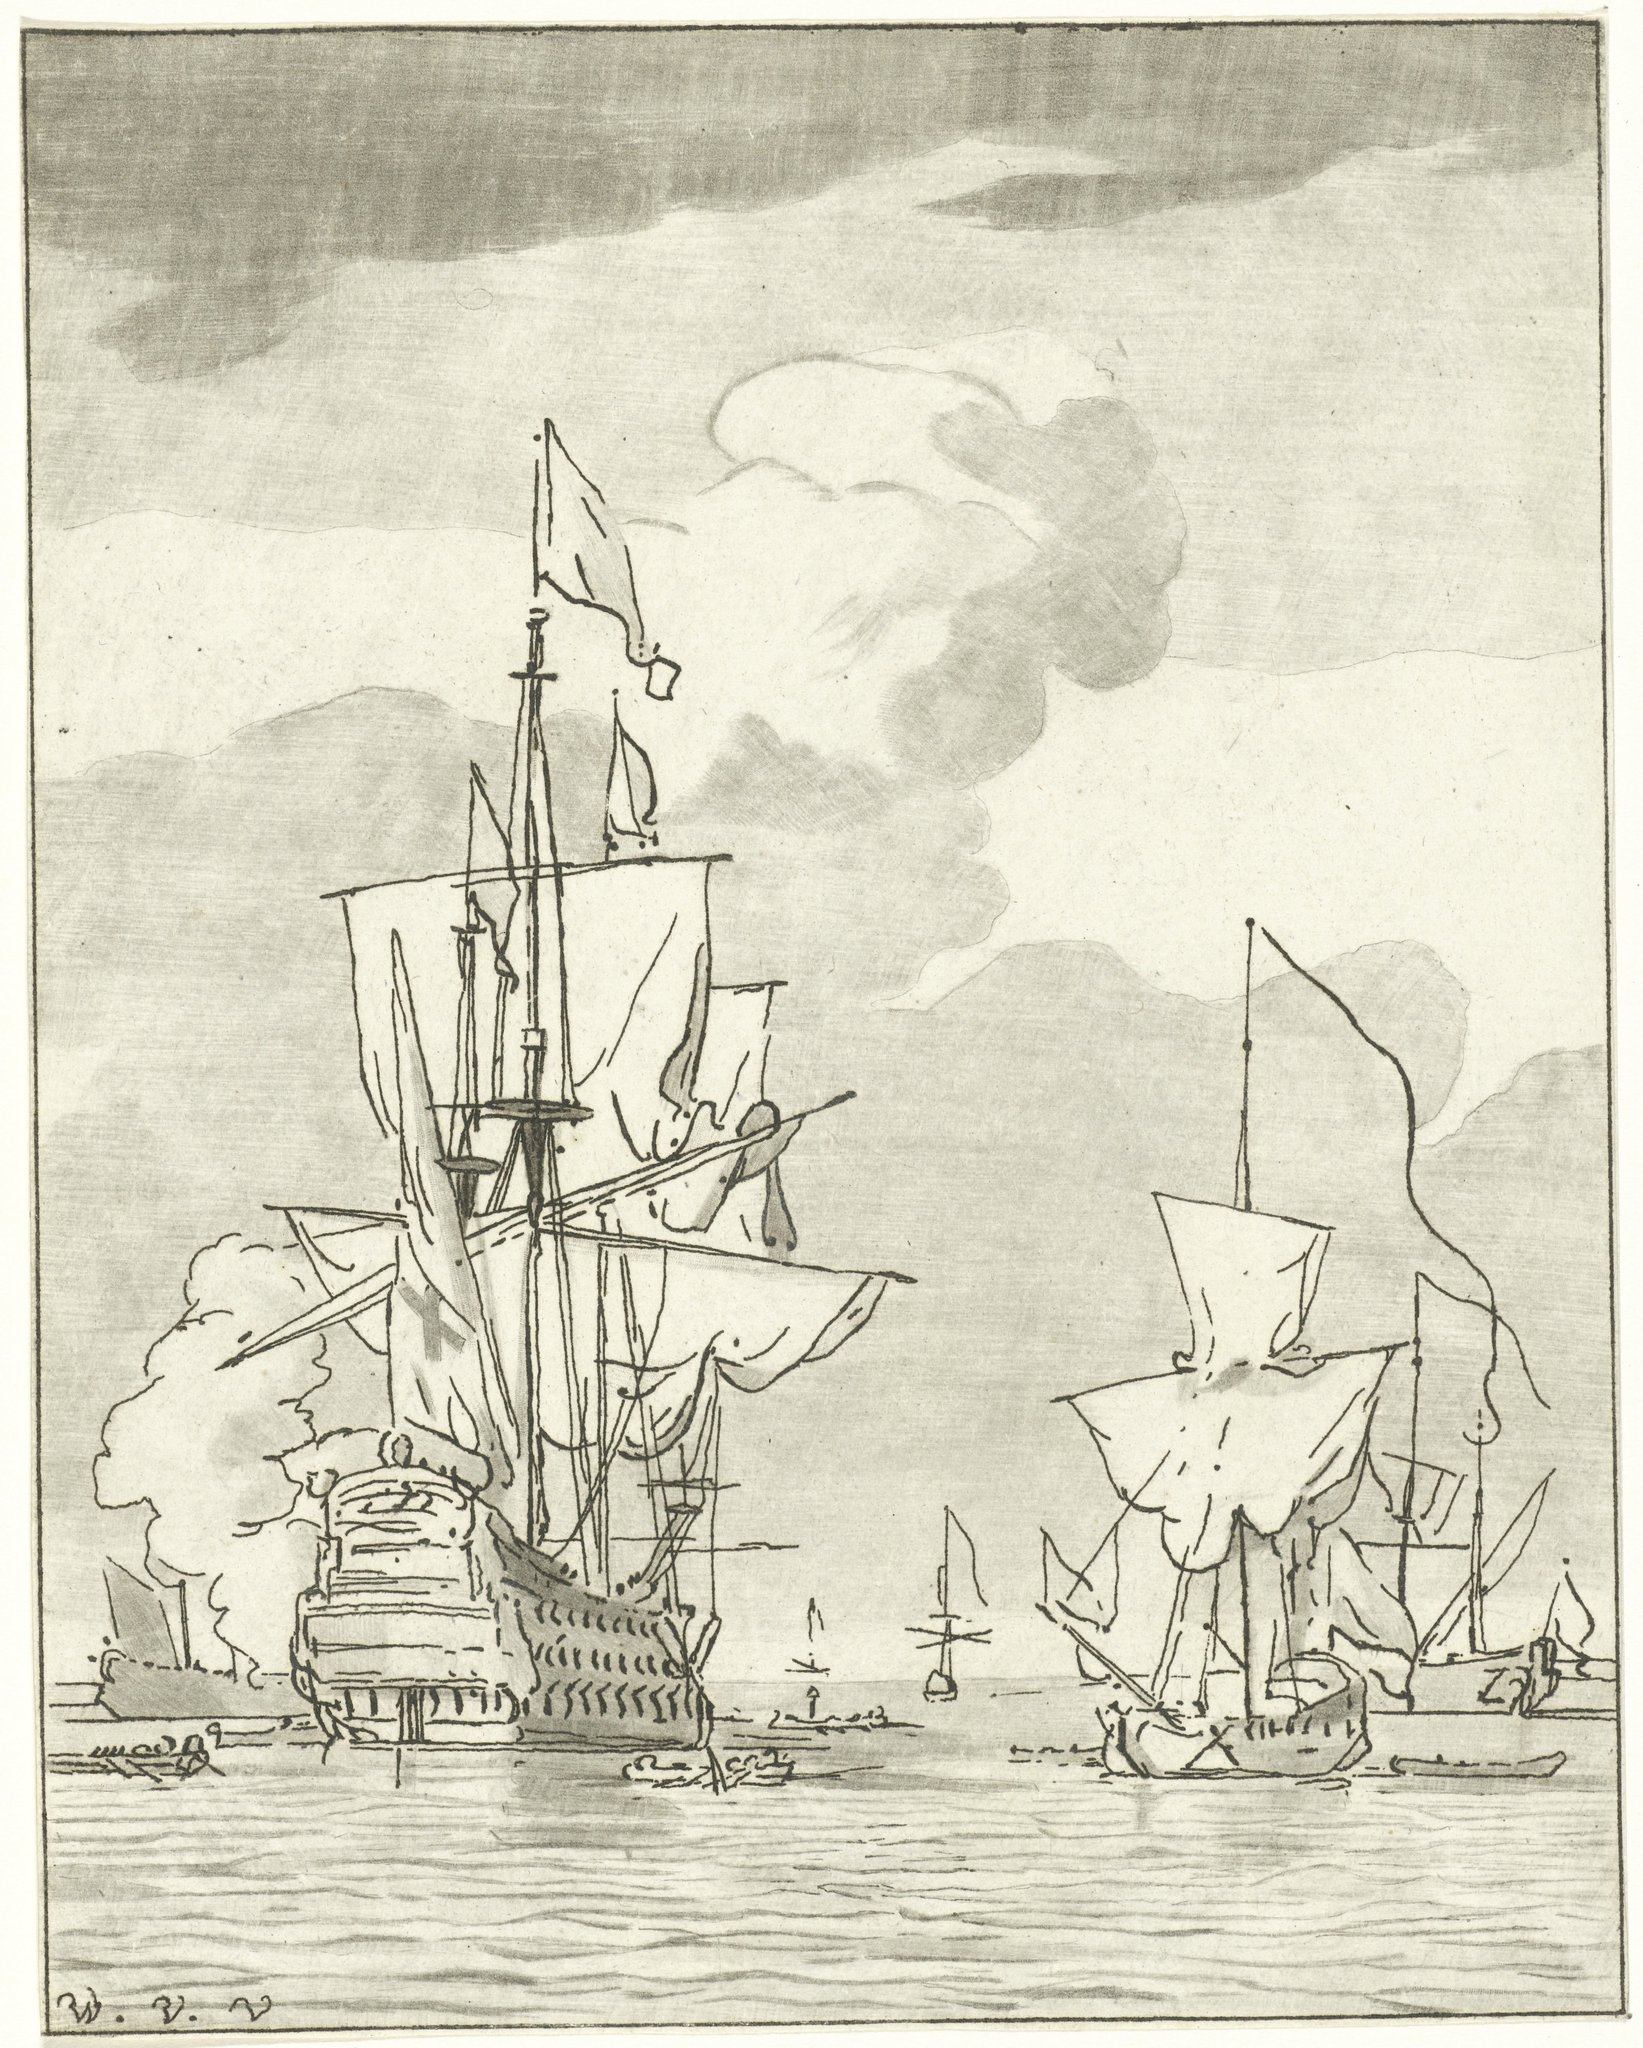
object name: print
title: Oorlogsschip een schot lossend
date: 1759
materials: paper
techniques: etching, roulette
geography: amsterdam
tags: sailing-ship, sailing-boat, cannon shots (military salute)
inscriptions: inscription: ‘Geoffreerd aan de WEd Heere van ... Ten verzoeke van mijnen Vriend de Heer ... W van de Velde del Ploos v Amstel fecit’, collector's mark: Lugt 240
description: Verschillende zeilschepen op zee, waarvan één een schot lost.